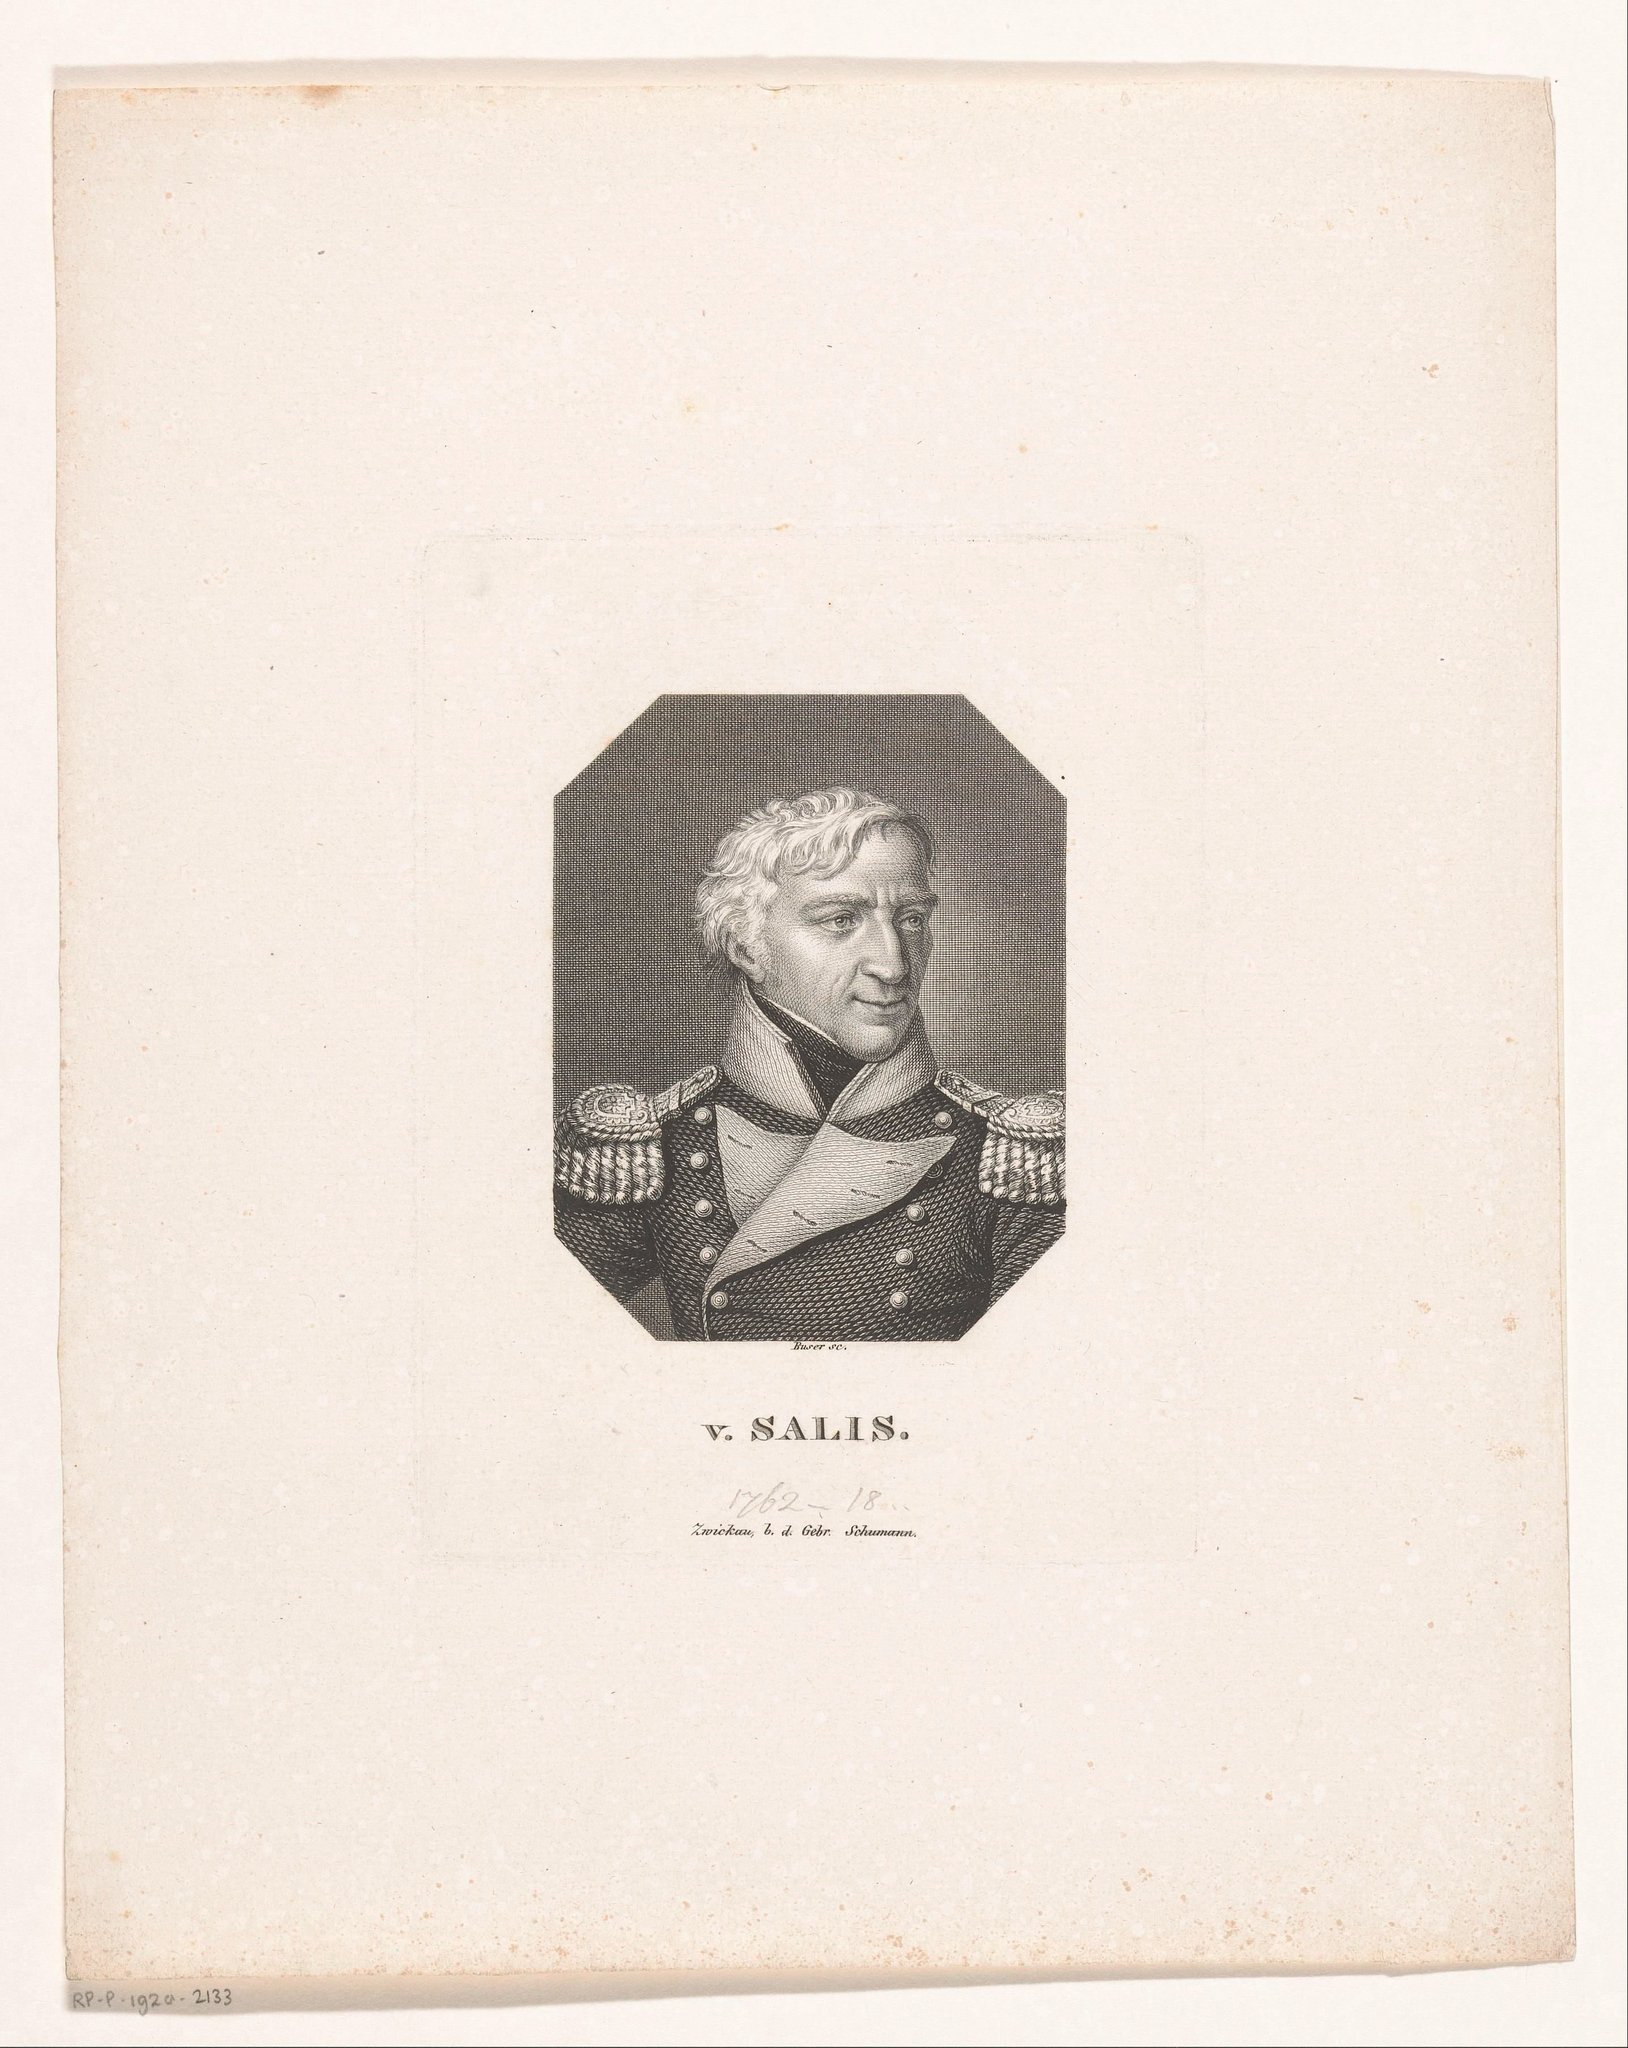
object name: print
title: Bildnisse der berühmtesten Menschen aller Völker und Zeiten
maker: friedrich buser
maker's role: print maker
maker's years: 1797-1833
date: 1818-1832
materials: paper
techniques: engraving, etching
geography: zwickau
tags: historical persons, (military) uniforms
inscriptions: collector's mark: Lugt 2228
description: Prent gebruikt door de serie 'Bildnisse der berühmtesten Menschen aller Völker und Zeiten' van de gebroeders Schumann, uitgegeven in 1818-1832 te Zwickau.